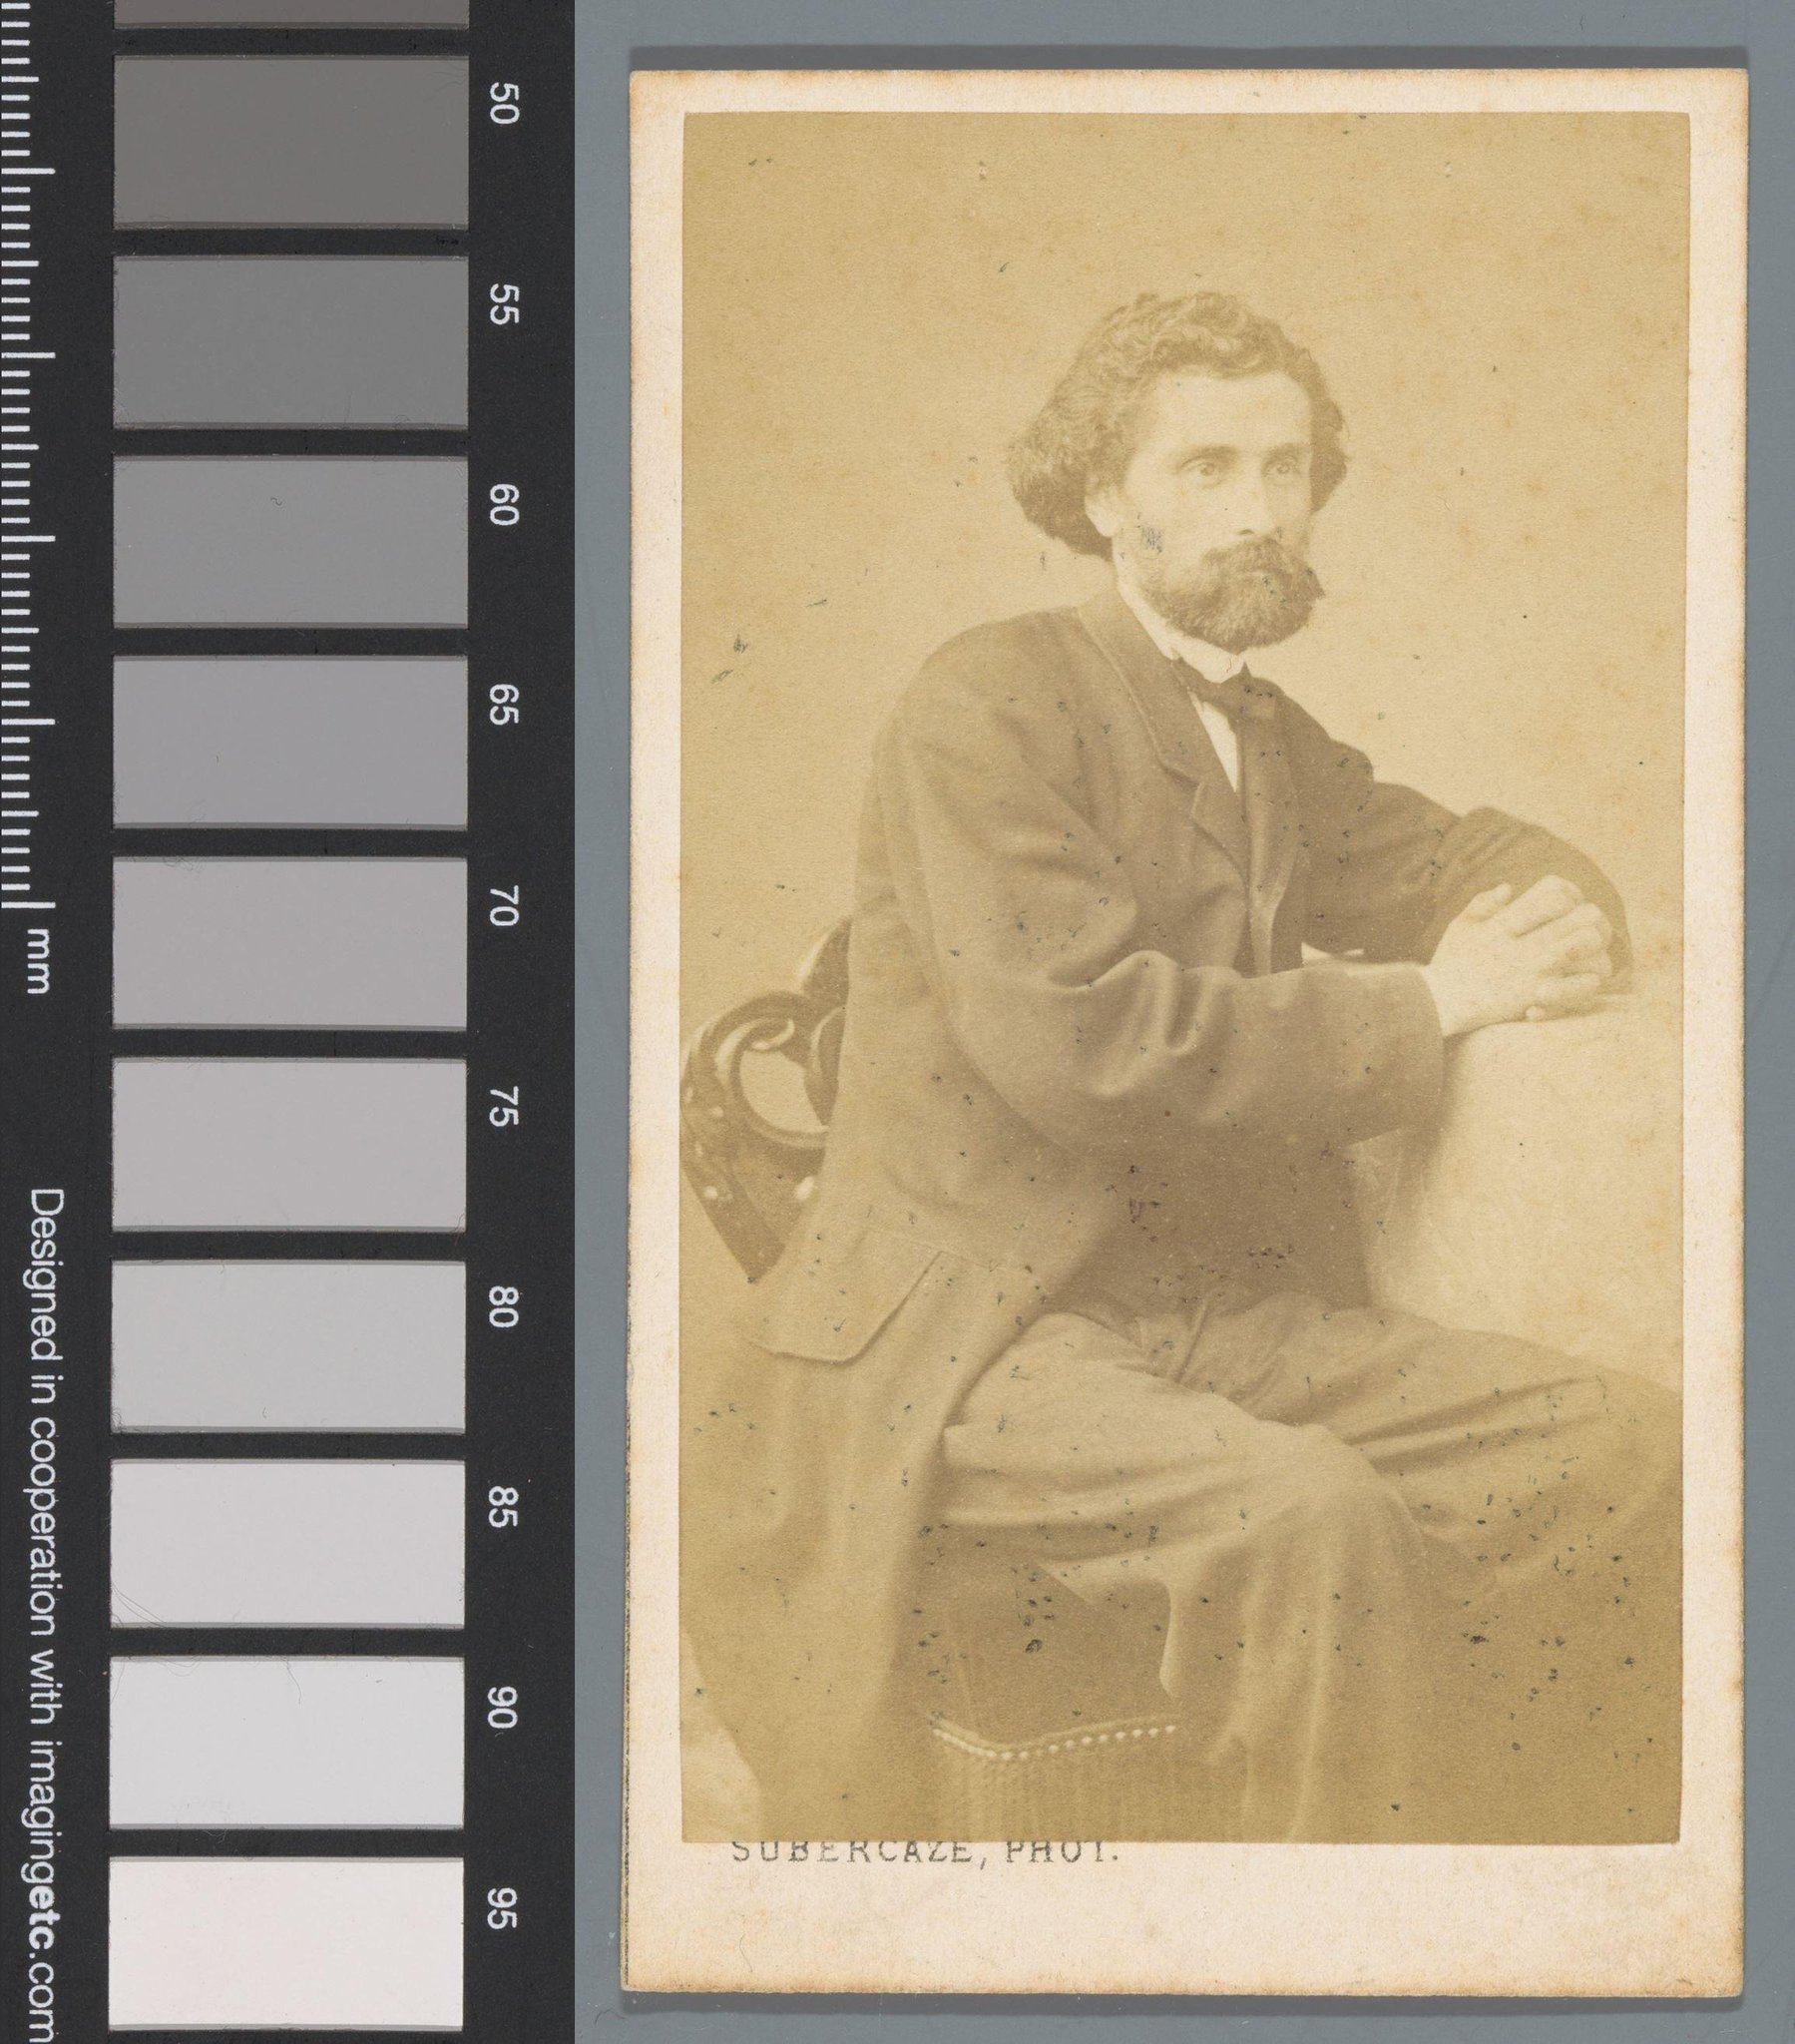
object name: carte de visite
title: Portret van Manuel Matamoros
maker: léon subercaze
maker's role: print maker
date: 1866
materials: cardboard, paper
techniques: albumen print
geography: pau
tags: clergyman, adult man, historical persons, beard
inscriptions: inscription: ‘Photographie/ L. Subercaze/ Artiste Peintre/ Pau’, inscription: ‘A la señorita Dña. Cor-/ nelia Steenlack en testimonia/ de gratitud por la rolle inte-/ ra en fevor dela evangelista/ con dela España/ Pau Marzo 28/1866/ Manuel Matamoros/ Boul. 8o.’, inscription: ‘Subercaze, phot.’